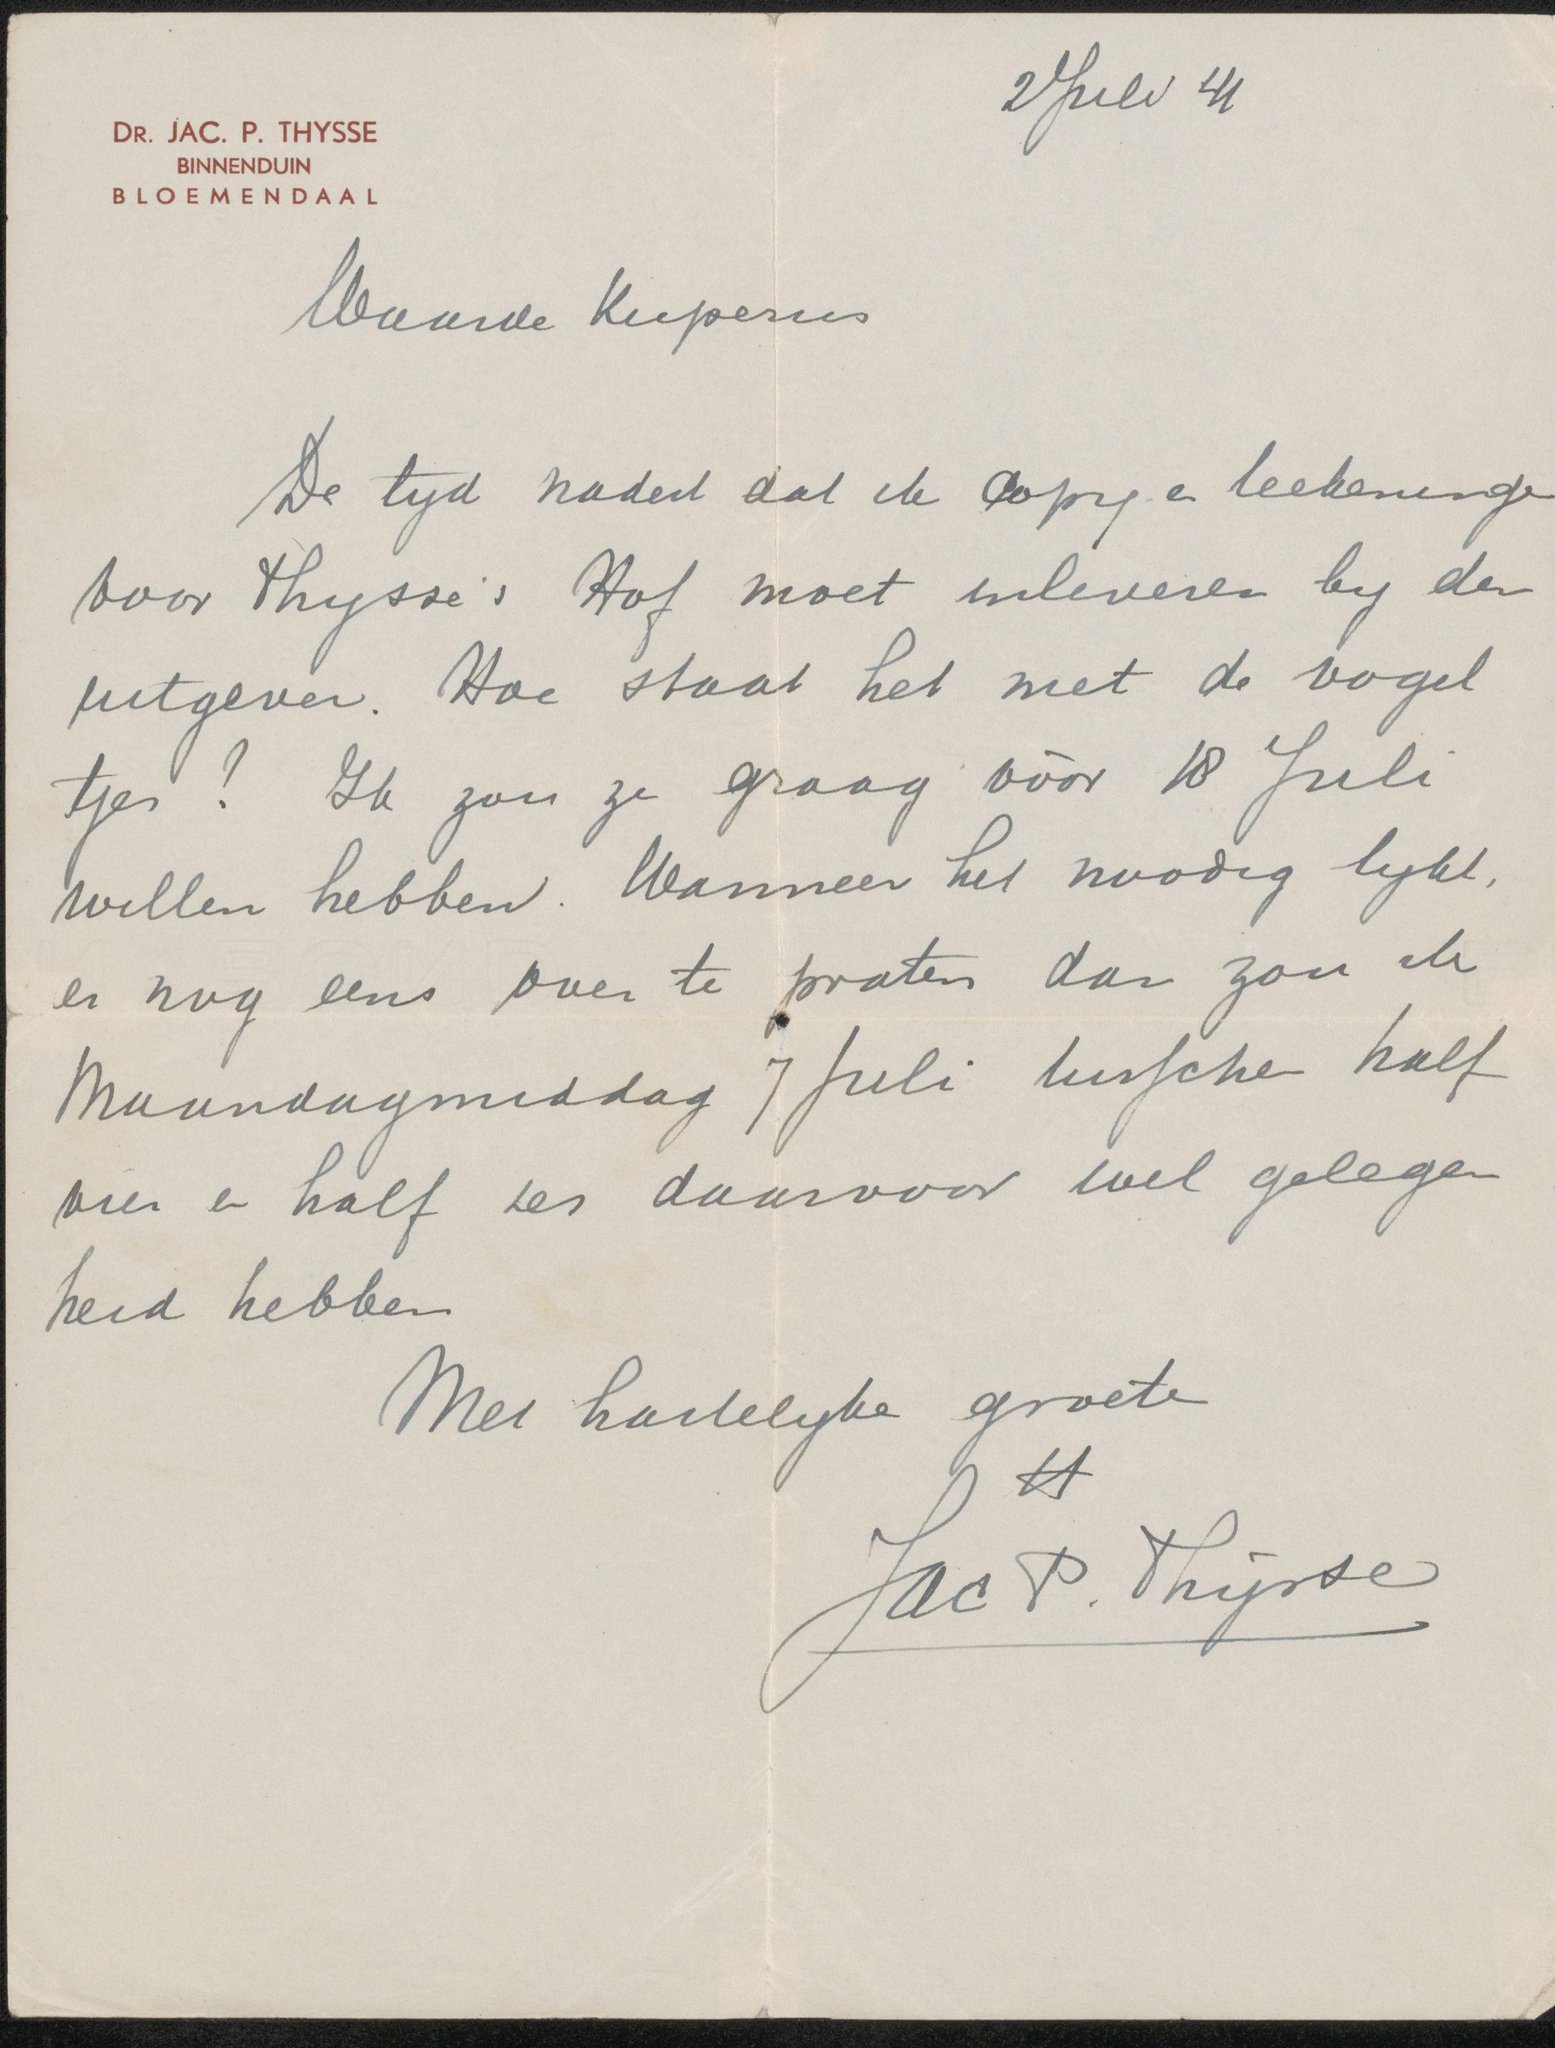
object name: letter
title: Brief aan Sjoerd Kuperus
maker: jac. p. thijsse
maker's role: bioloog, onderwijzer, schrijver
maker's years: 1865-1945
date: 1941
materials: ink, paper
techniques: pen, printing, writing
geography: bloemendaal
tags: print maker, draughtsman, sjoerd kuperus, illustration ~ printed matter, book, printed matter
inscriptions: collector's mark: ‘RPK’, watermark